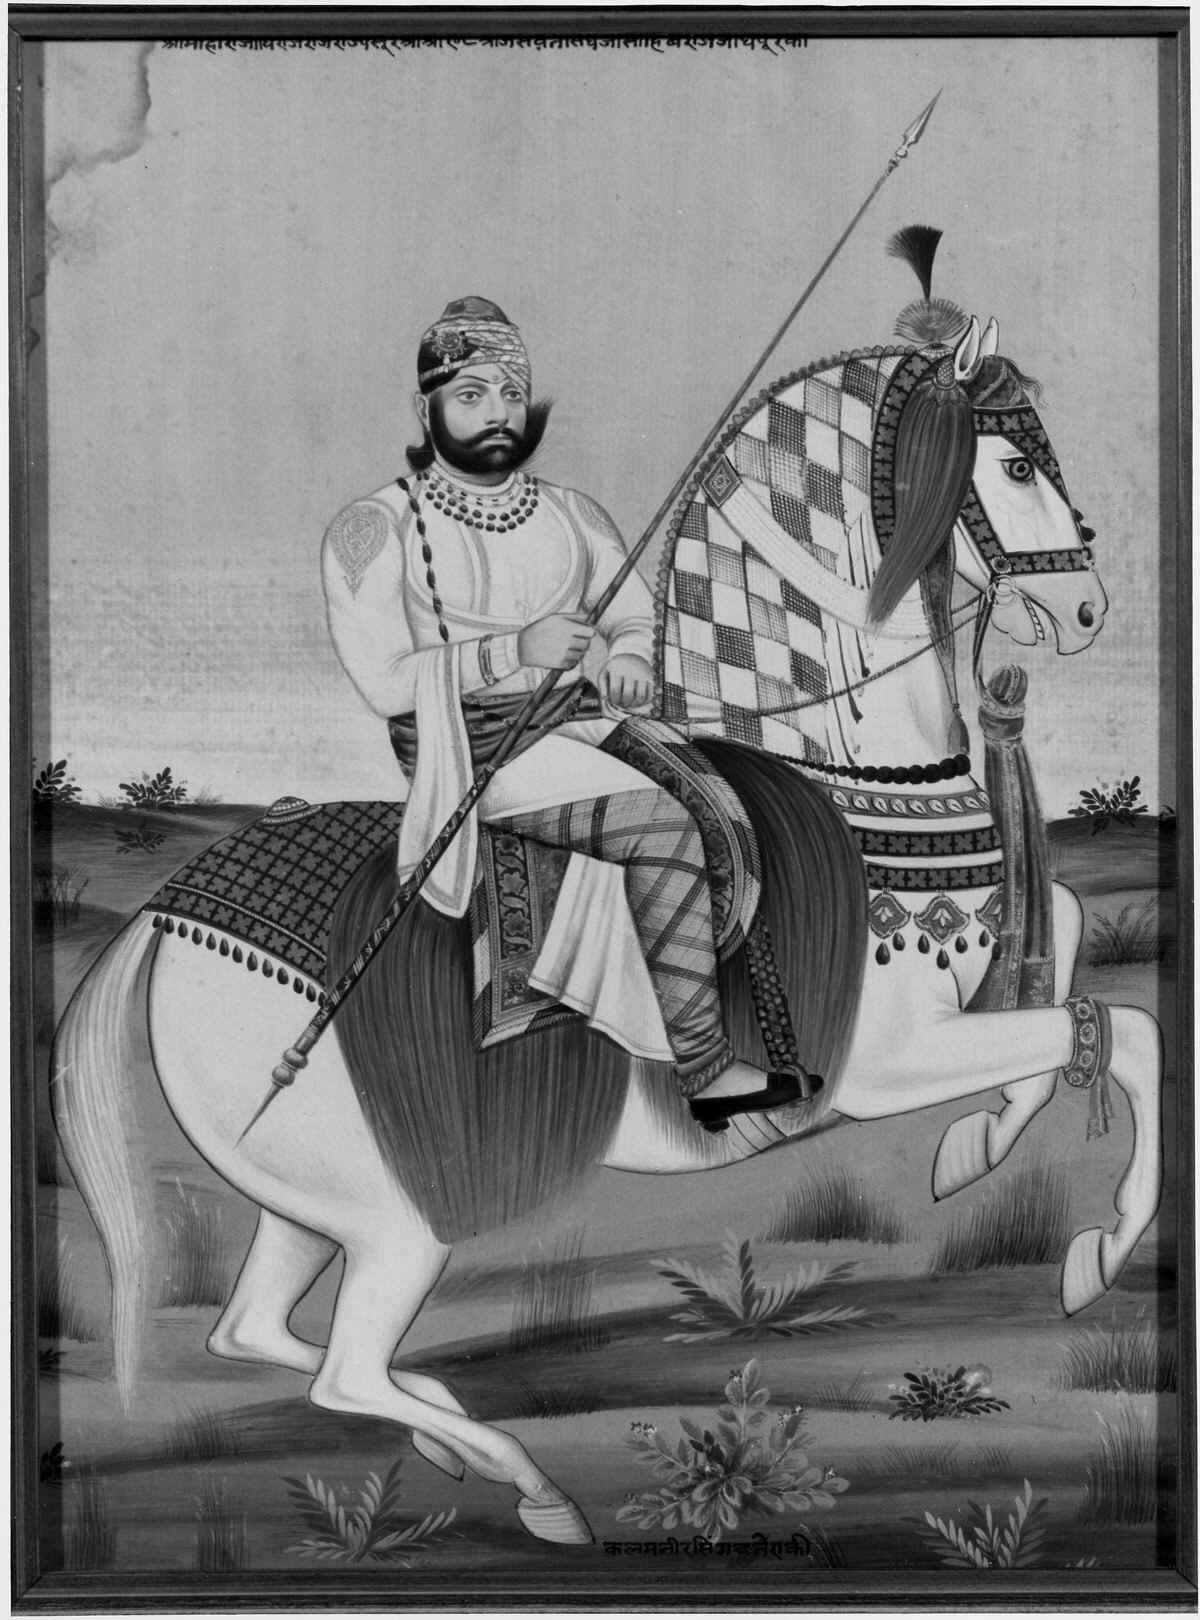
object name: painting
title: Equestrian Portrait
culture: indian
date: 1867-1933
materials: gold, paper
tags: men,portraits,horses